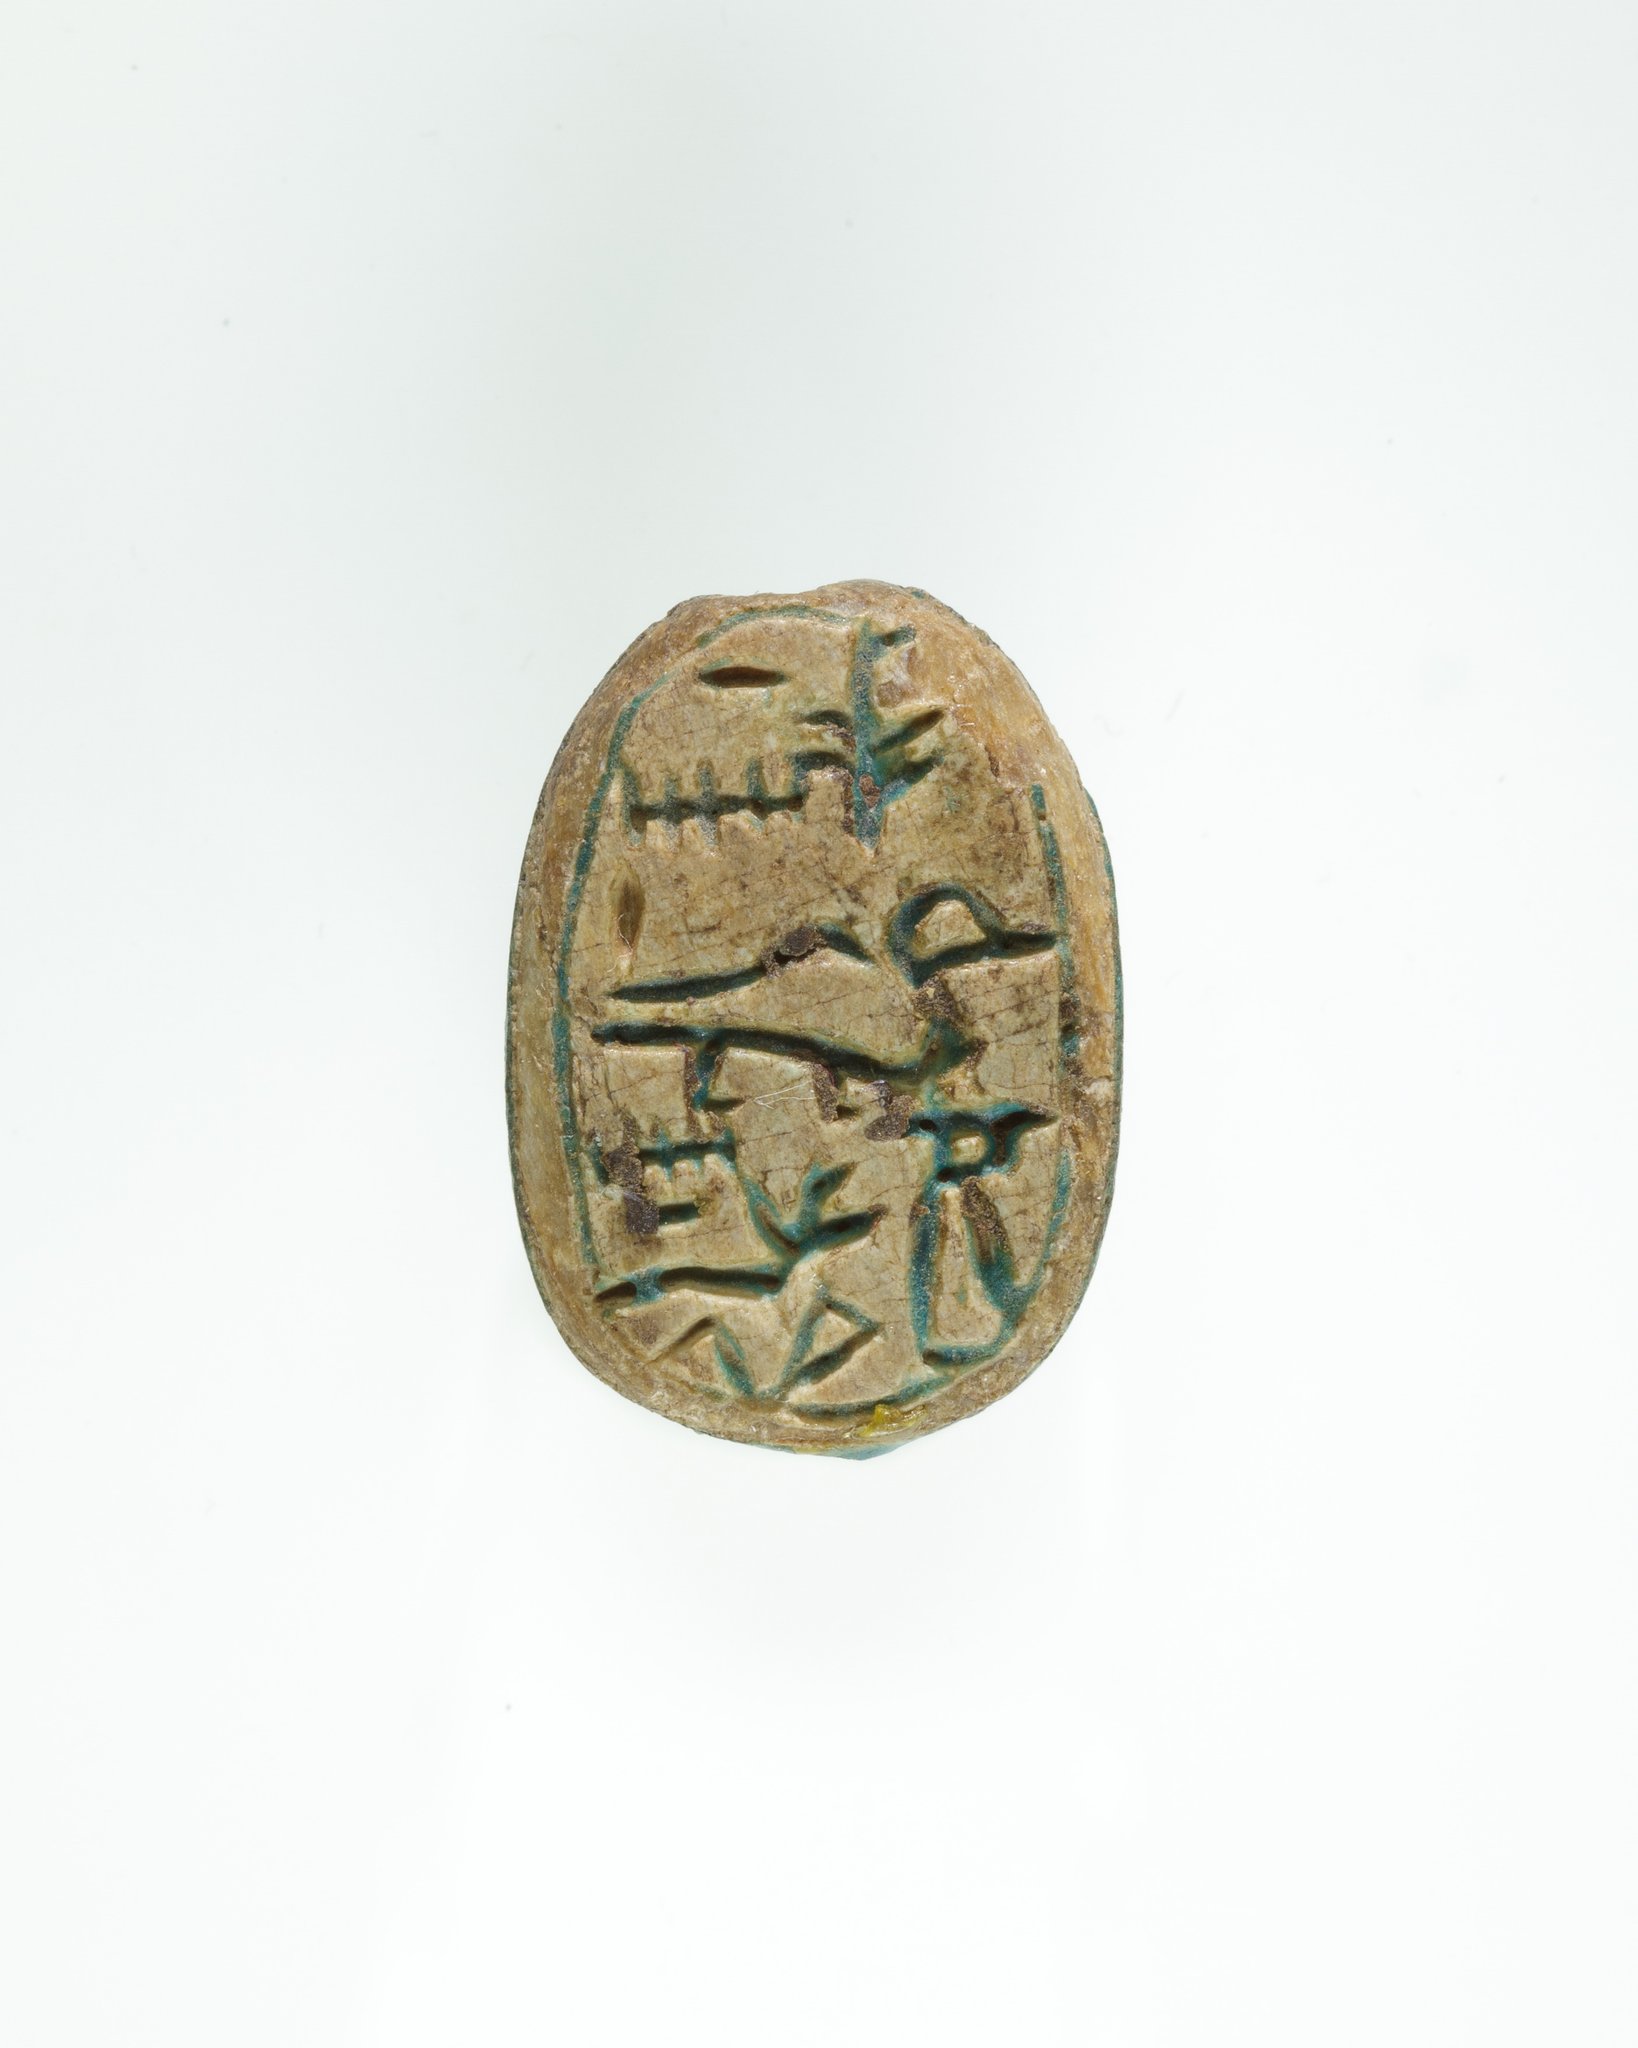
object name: scarab, intef, king's son, hieroglyph, royal title, prince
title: Scarab of King's Son Intef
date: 1760-1670 BCE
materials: stone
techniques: glazing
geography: egypt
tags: hieroglyphs,scarabs